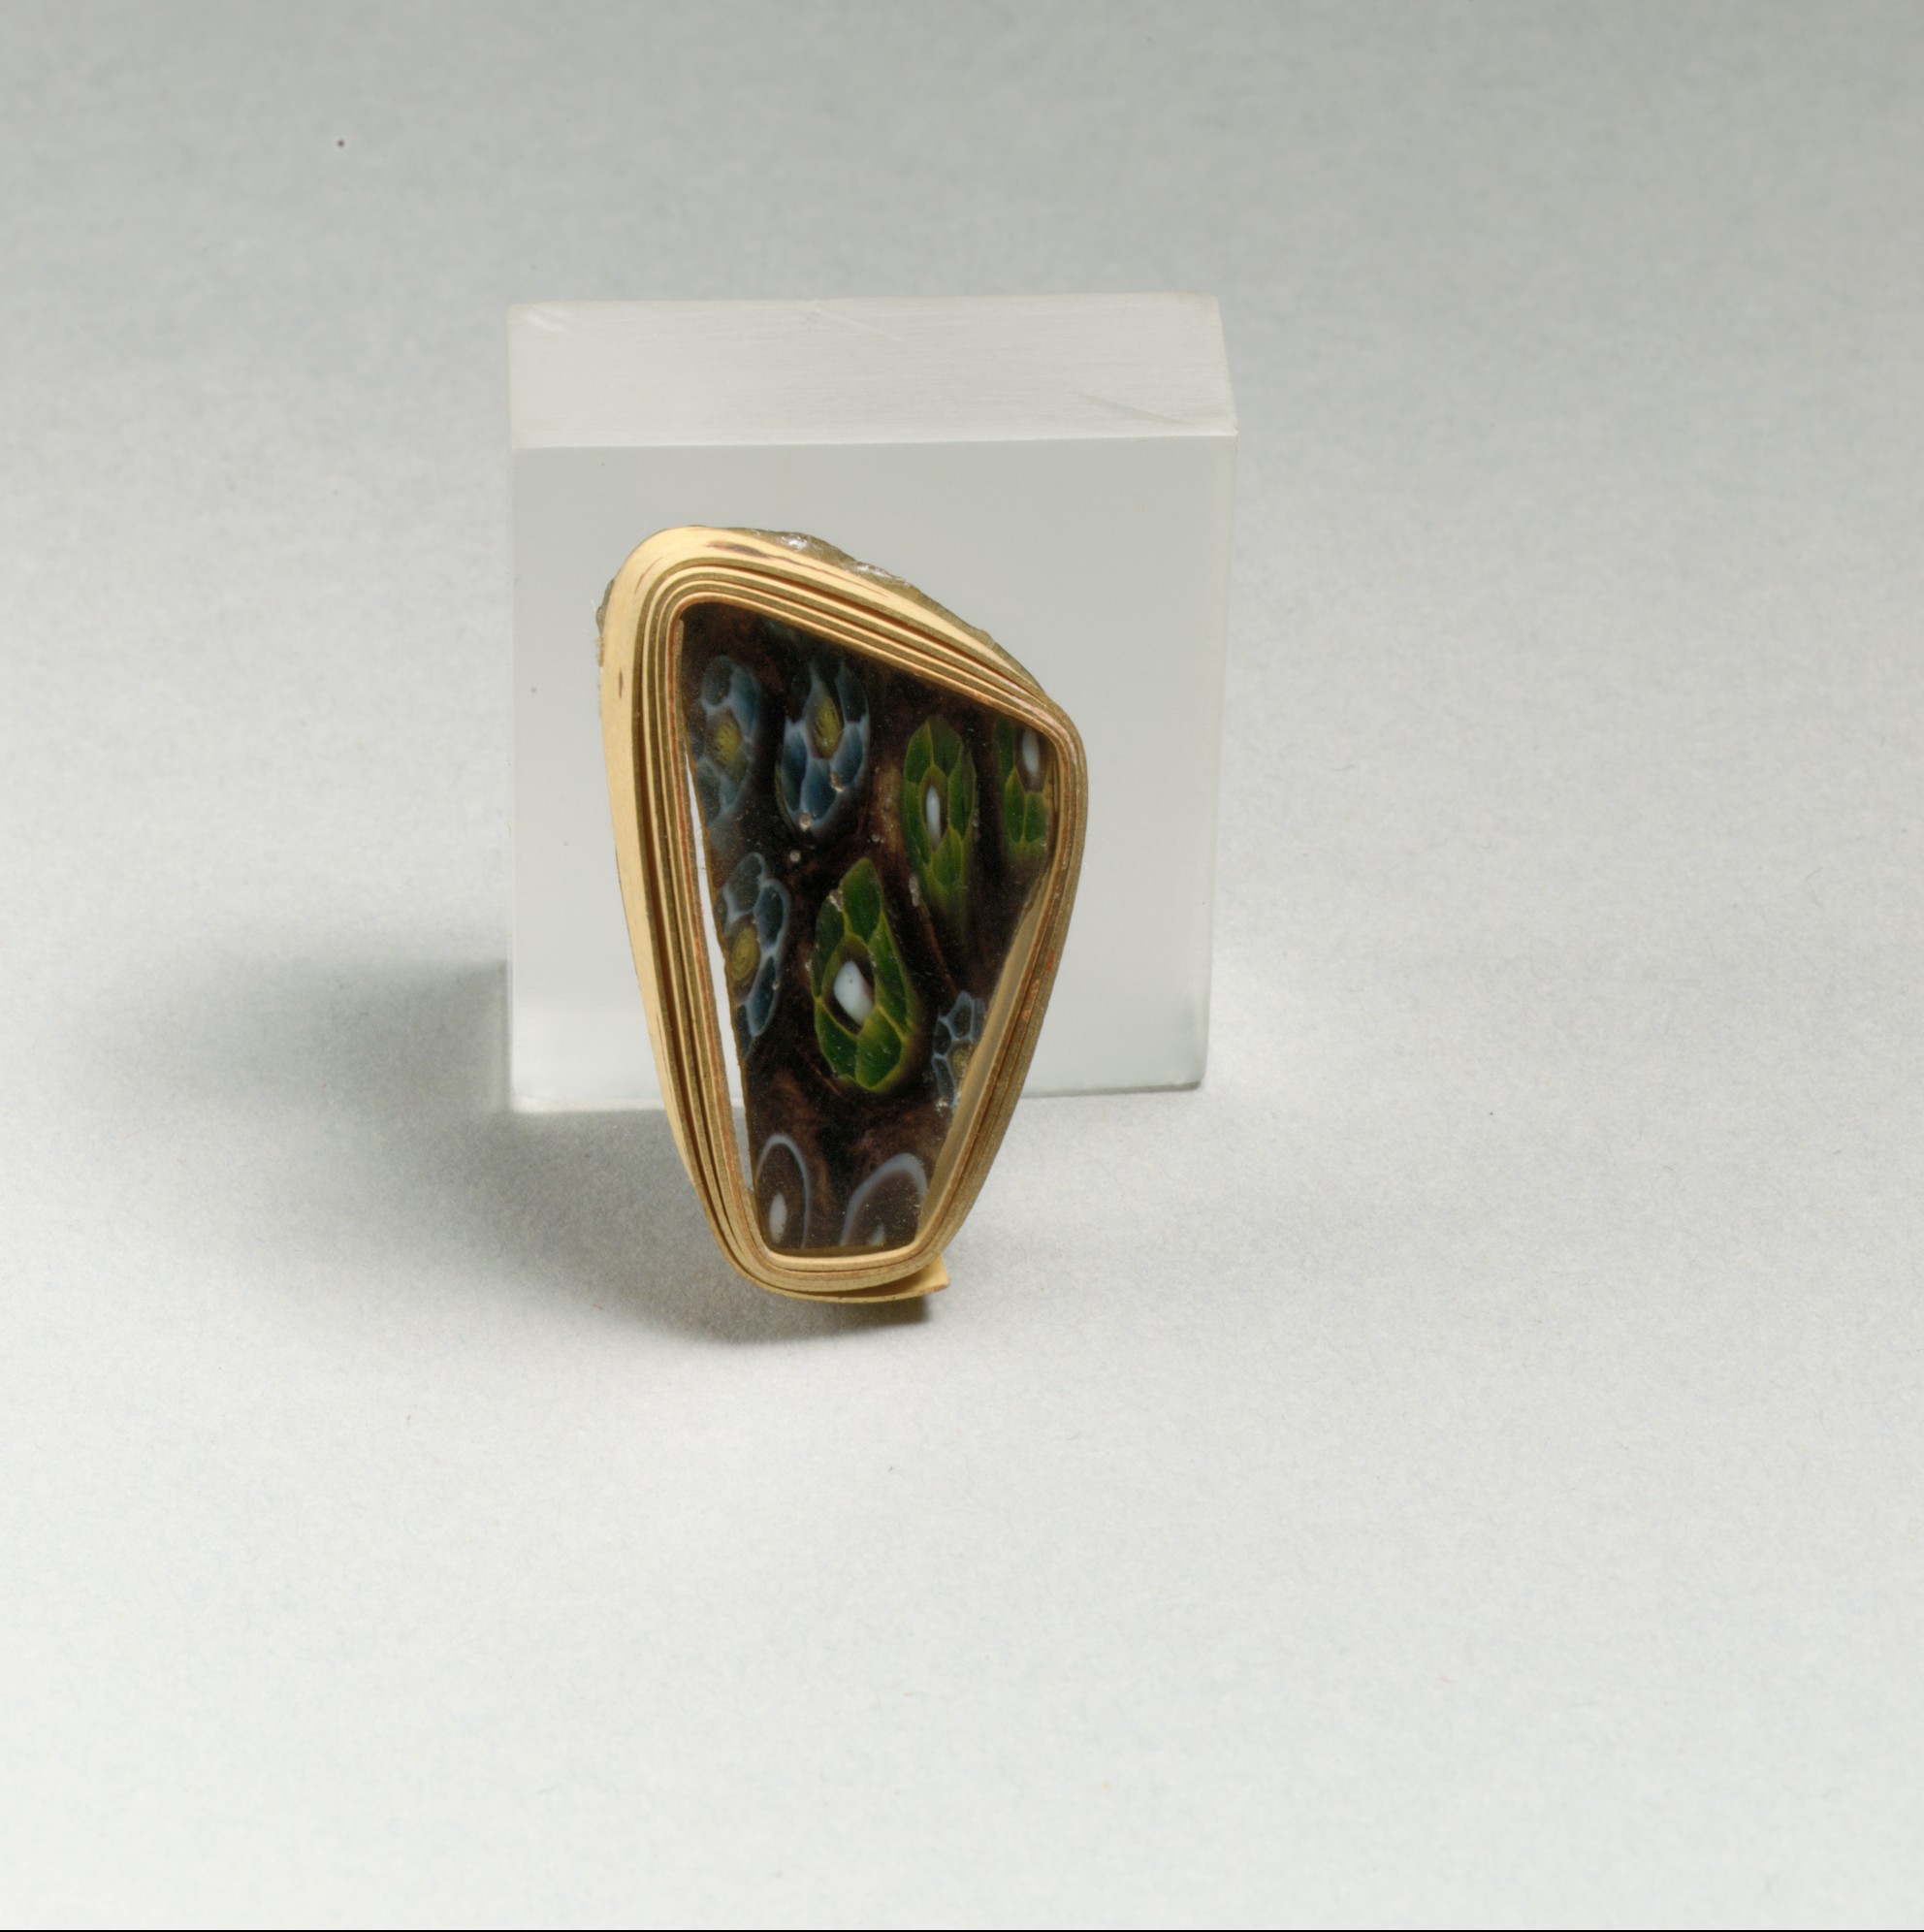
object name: fragment, mosaic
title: Glass mosaic inlay fragment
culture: roman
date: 34 BCE-33 CE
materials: glass